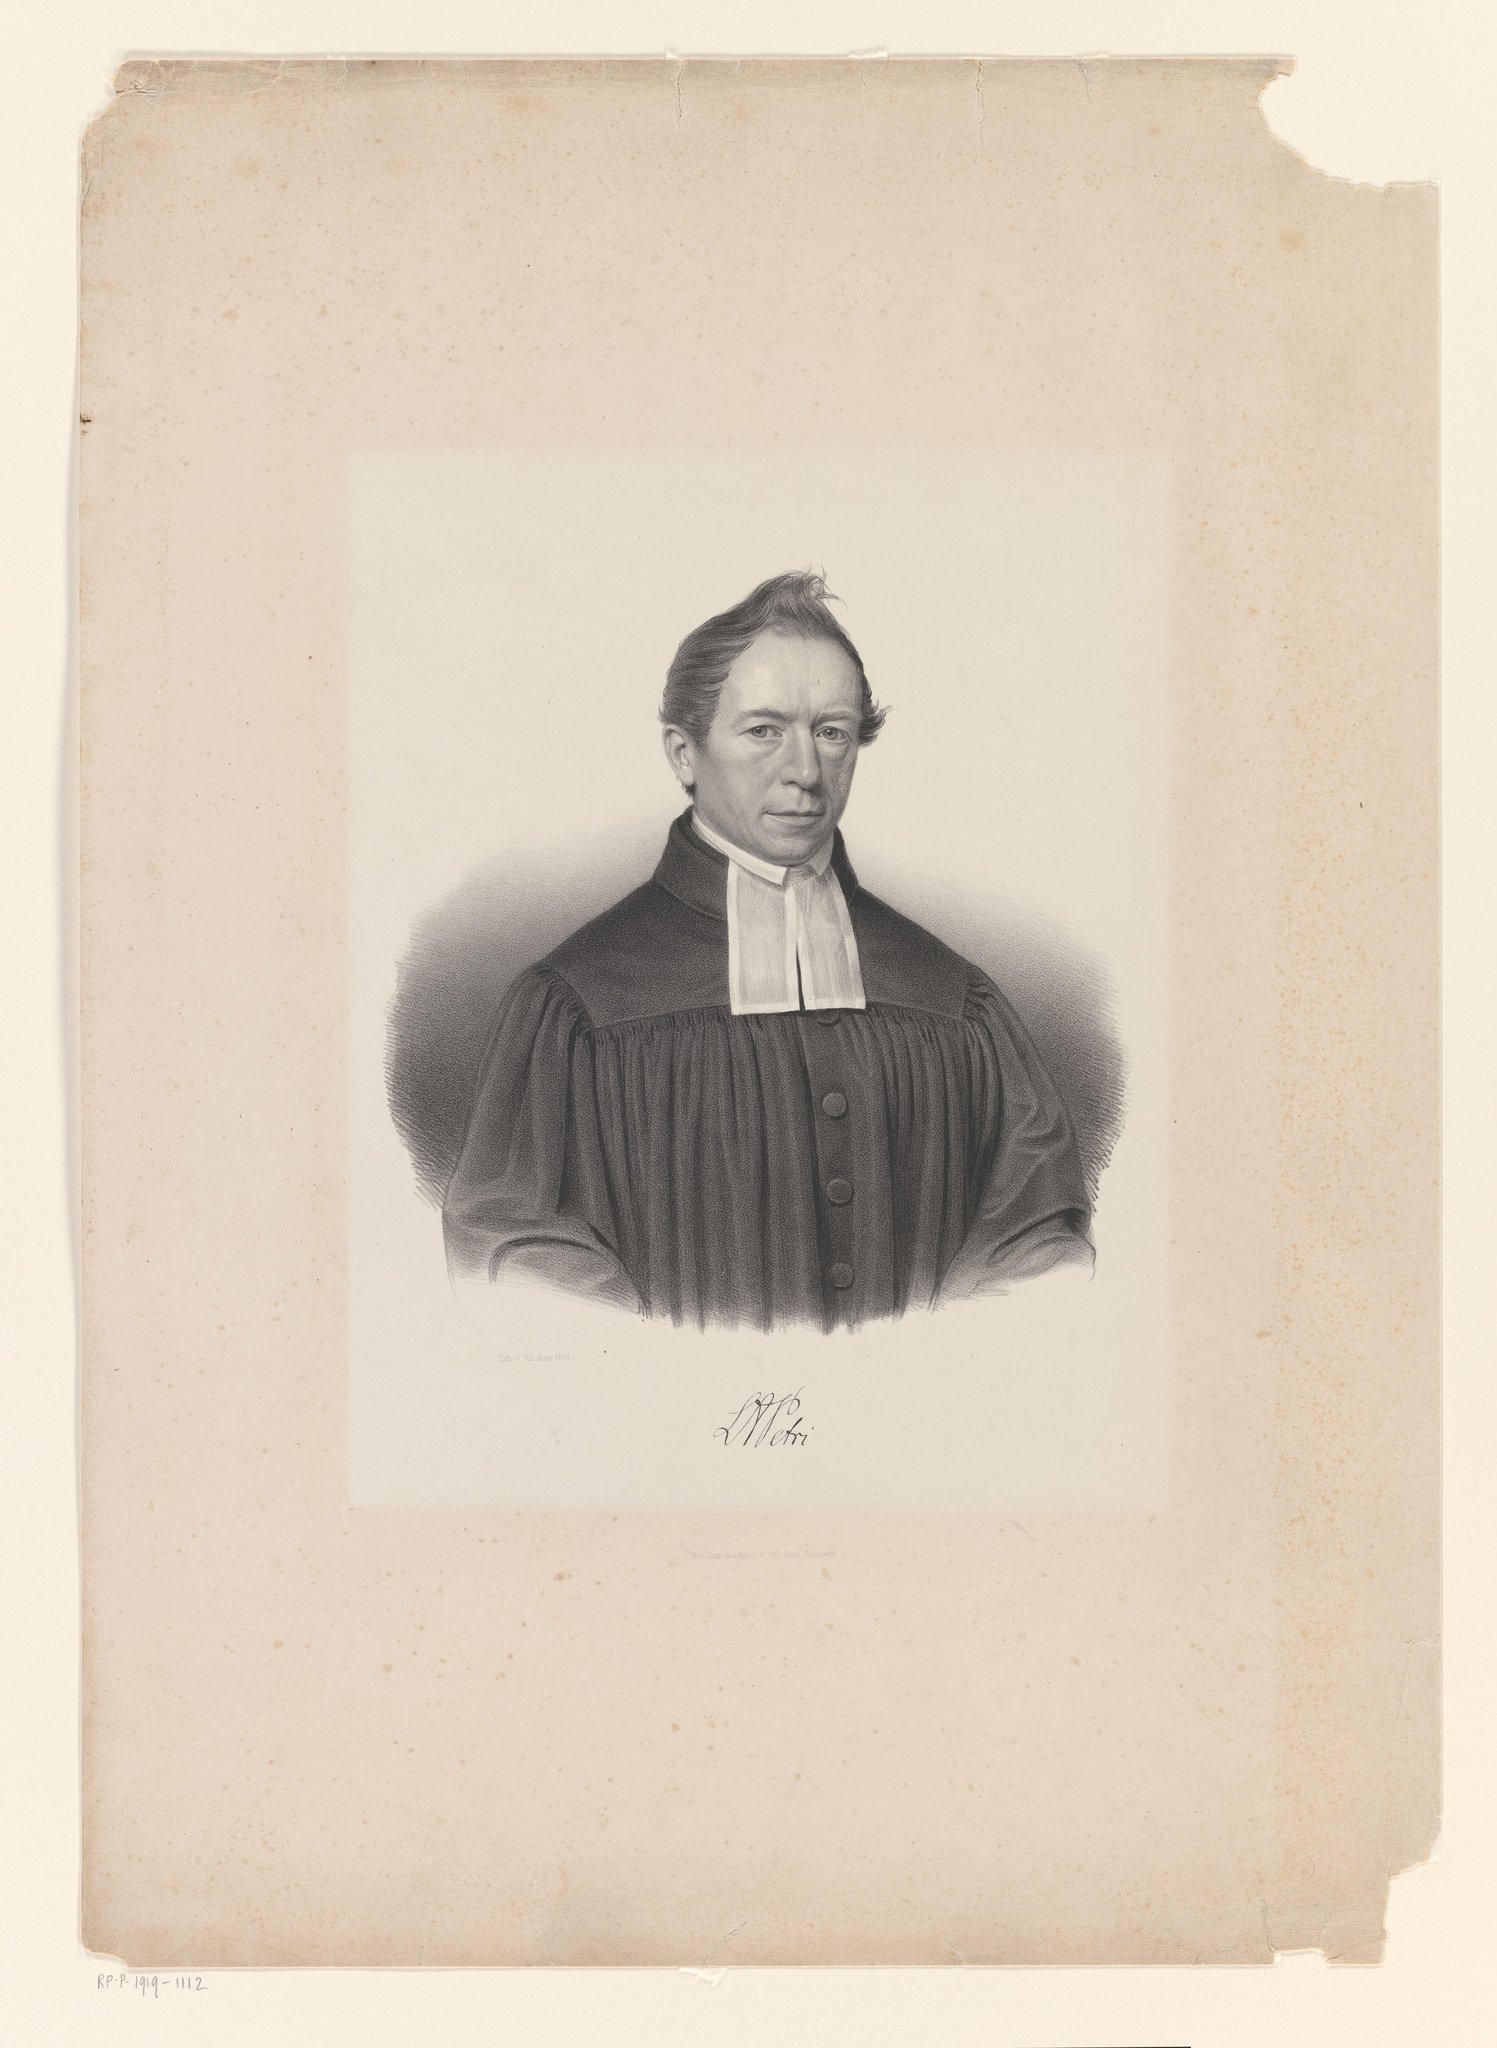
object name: print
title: Portret van Ludwig Adolf Petri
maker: julius giere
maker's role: print maker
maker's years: 1807-1880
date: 1850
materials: paper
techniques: lithograph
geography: hannover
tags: adult man, historical persons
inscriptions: collector's mark: Lugt 2228